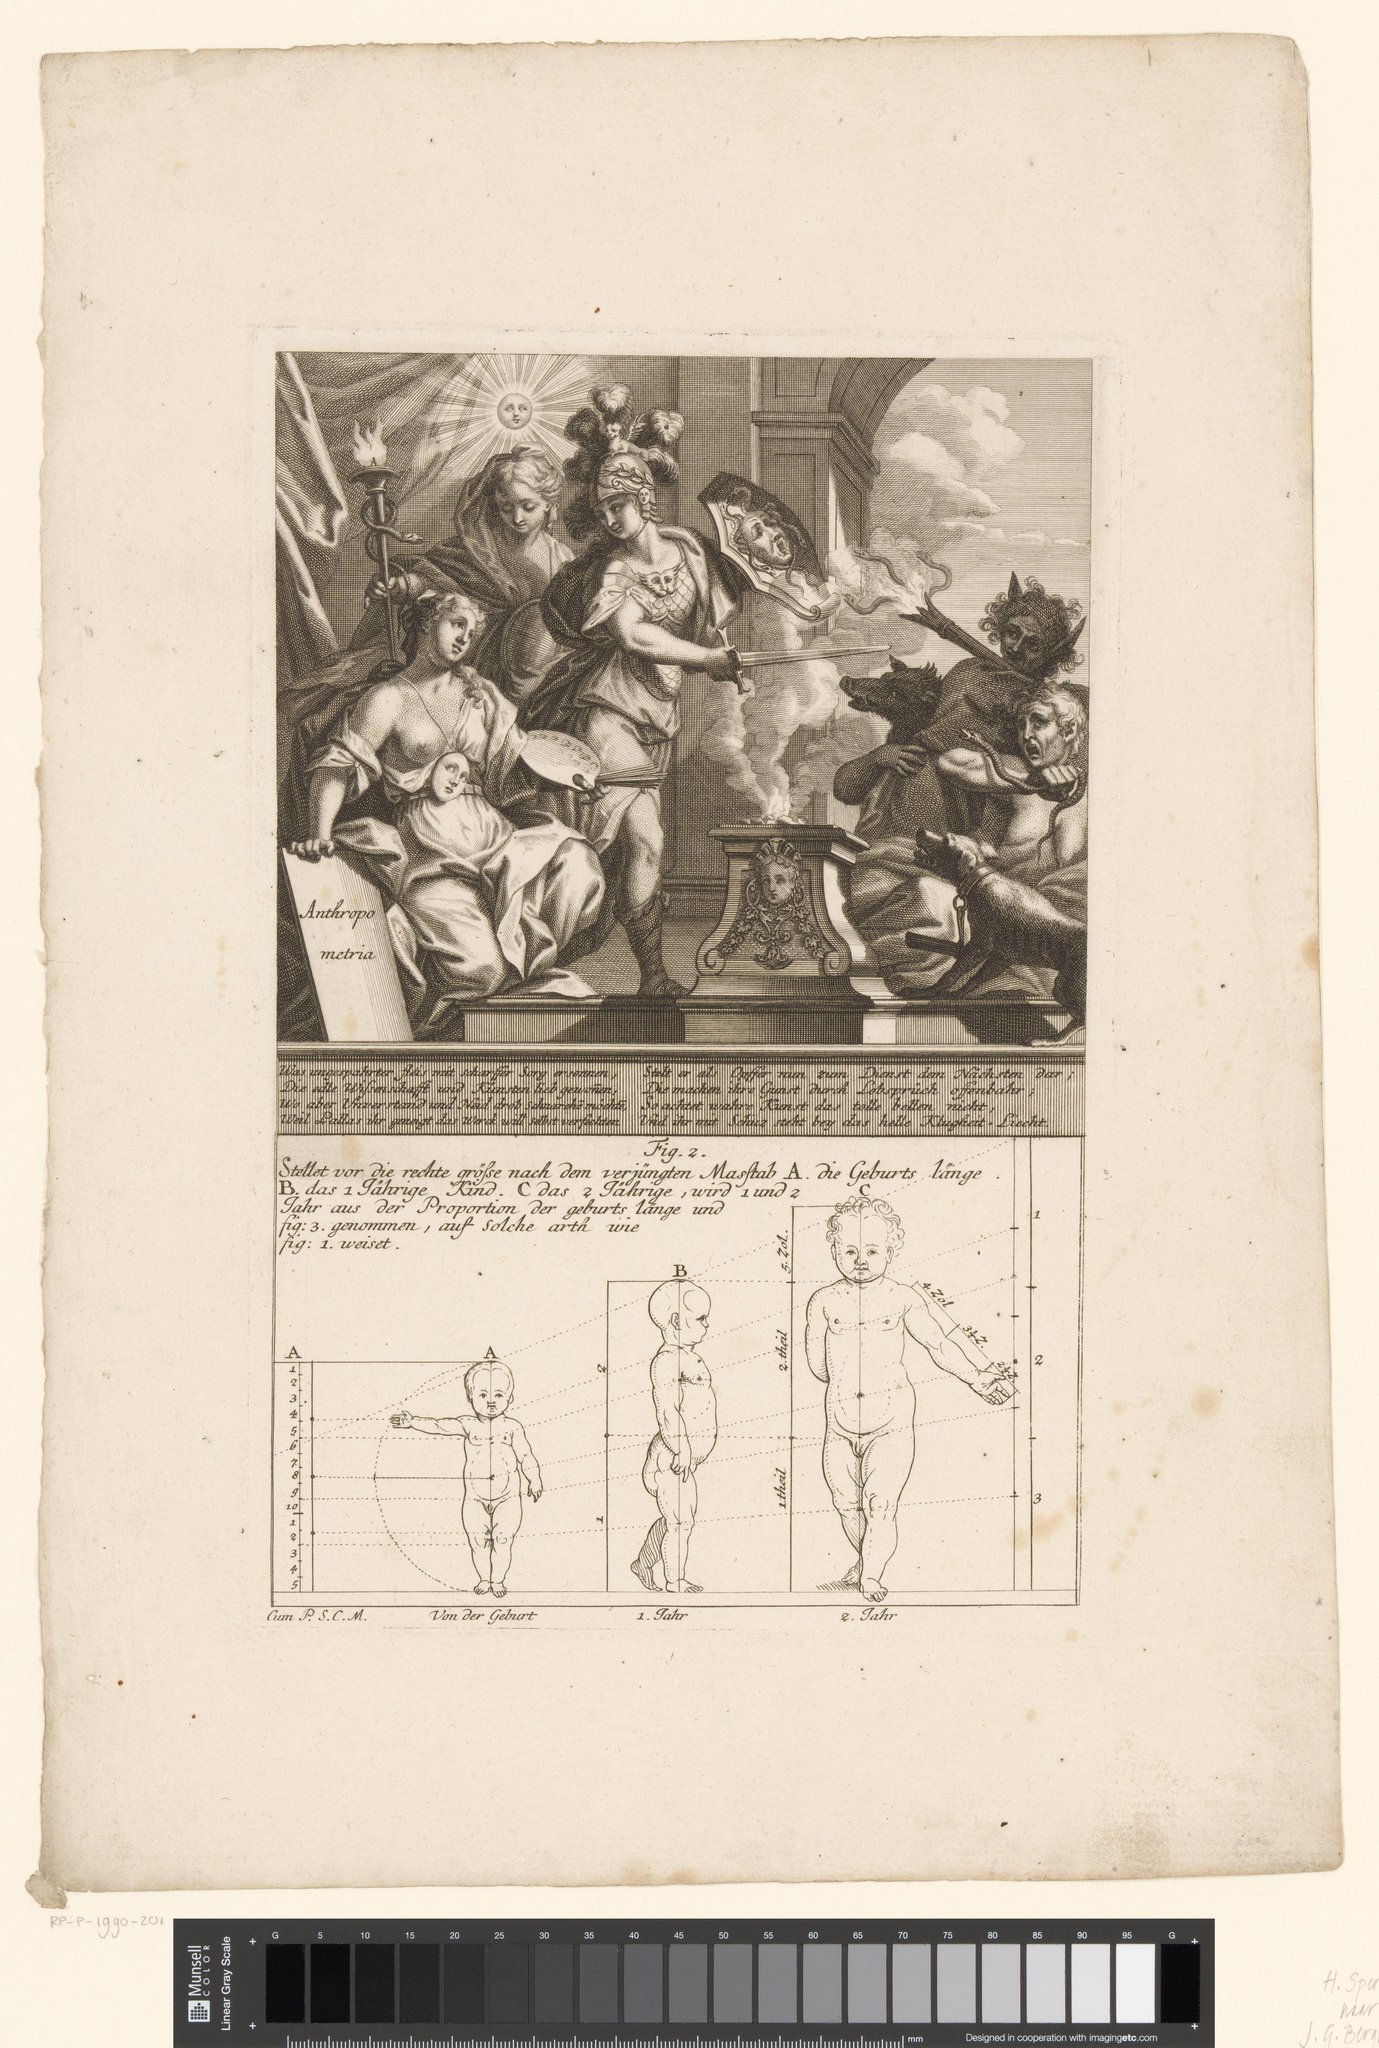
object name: print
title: Allegorie en drie aanzichten van het lichaam van een eenjarige jongen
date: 1723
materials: paper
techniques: engraving, etching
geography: augsburg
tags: standing figure, human life and its ages (young, adult, old, etc.), 'pictura', symbolic representations, allegories and emblems ~ painting; 'pittura' (ripa), sloth, indolence, 'acedia', 'desidia'; 'accidia' (ripa) ~ personification of one of the seven deadly sins, (story of) minerva (pallas, athena), child, standing figure (canon, proportions), invidia (envy) as roman personification, man (showing himself) undressed, quasi-nude, prudentia (prudence) as roman personification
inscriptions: collector's mark: Lugt 2760, collector's mark: Lugt 2228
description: Allegorische scène waarin Voorzichtigheid en Minerva de Schilderkunst beschermen tegen Luiheid en Afgunst. Midden: Fig. 2.